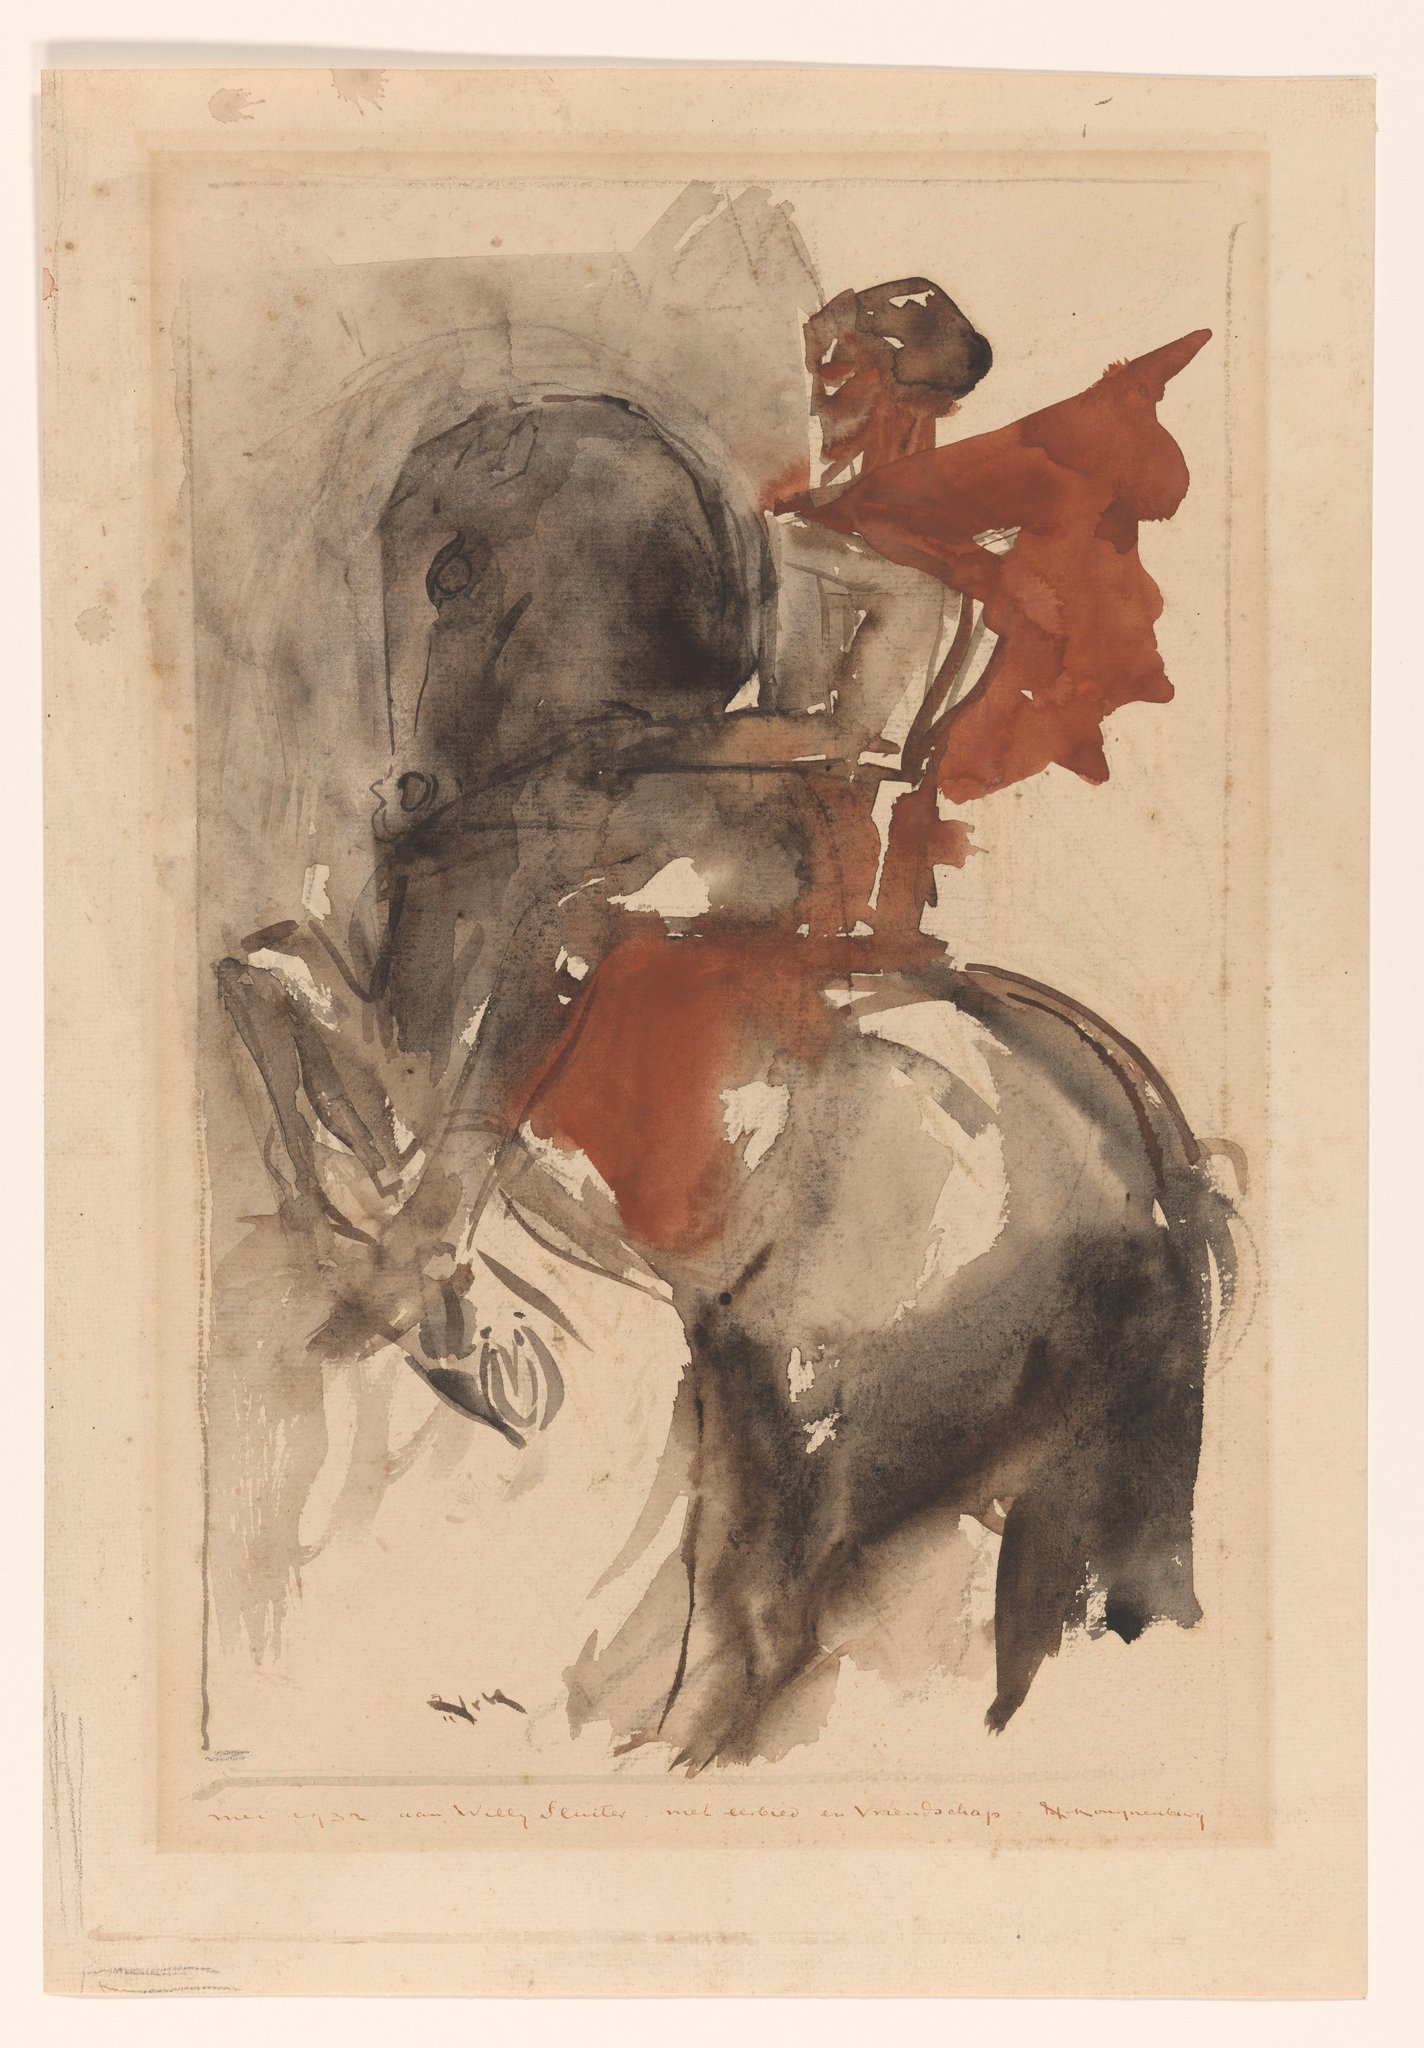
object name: drawing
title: Ridder te paard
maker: willem van konijnenburg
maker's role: draughtsman, painter, print maker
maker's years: 1868-1943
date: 1878-1943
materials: paper, watercolor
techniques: brush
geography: the hague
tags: riding a horse, ass, or mule; rider, horseman, armour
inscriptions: signature: ‘WvK’